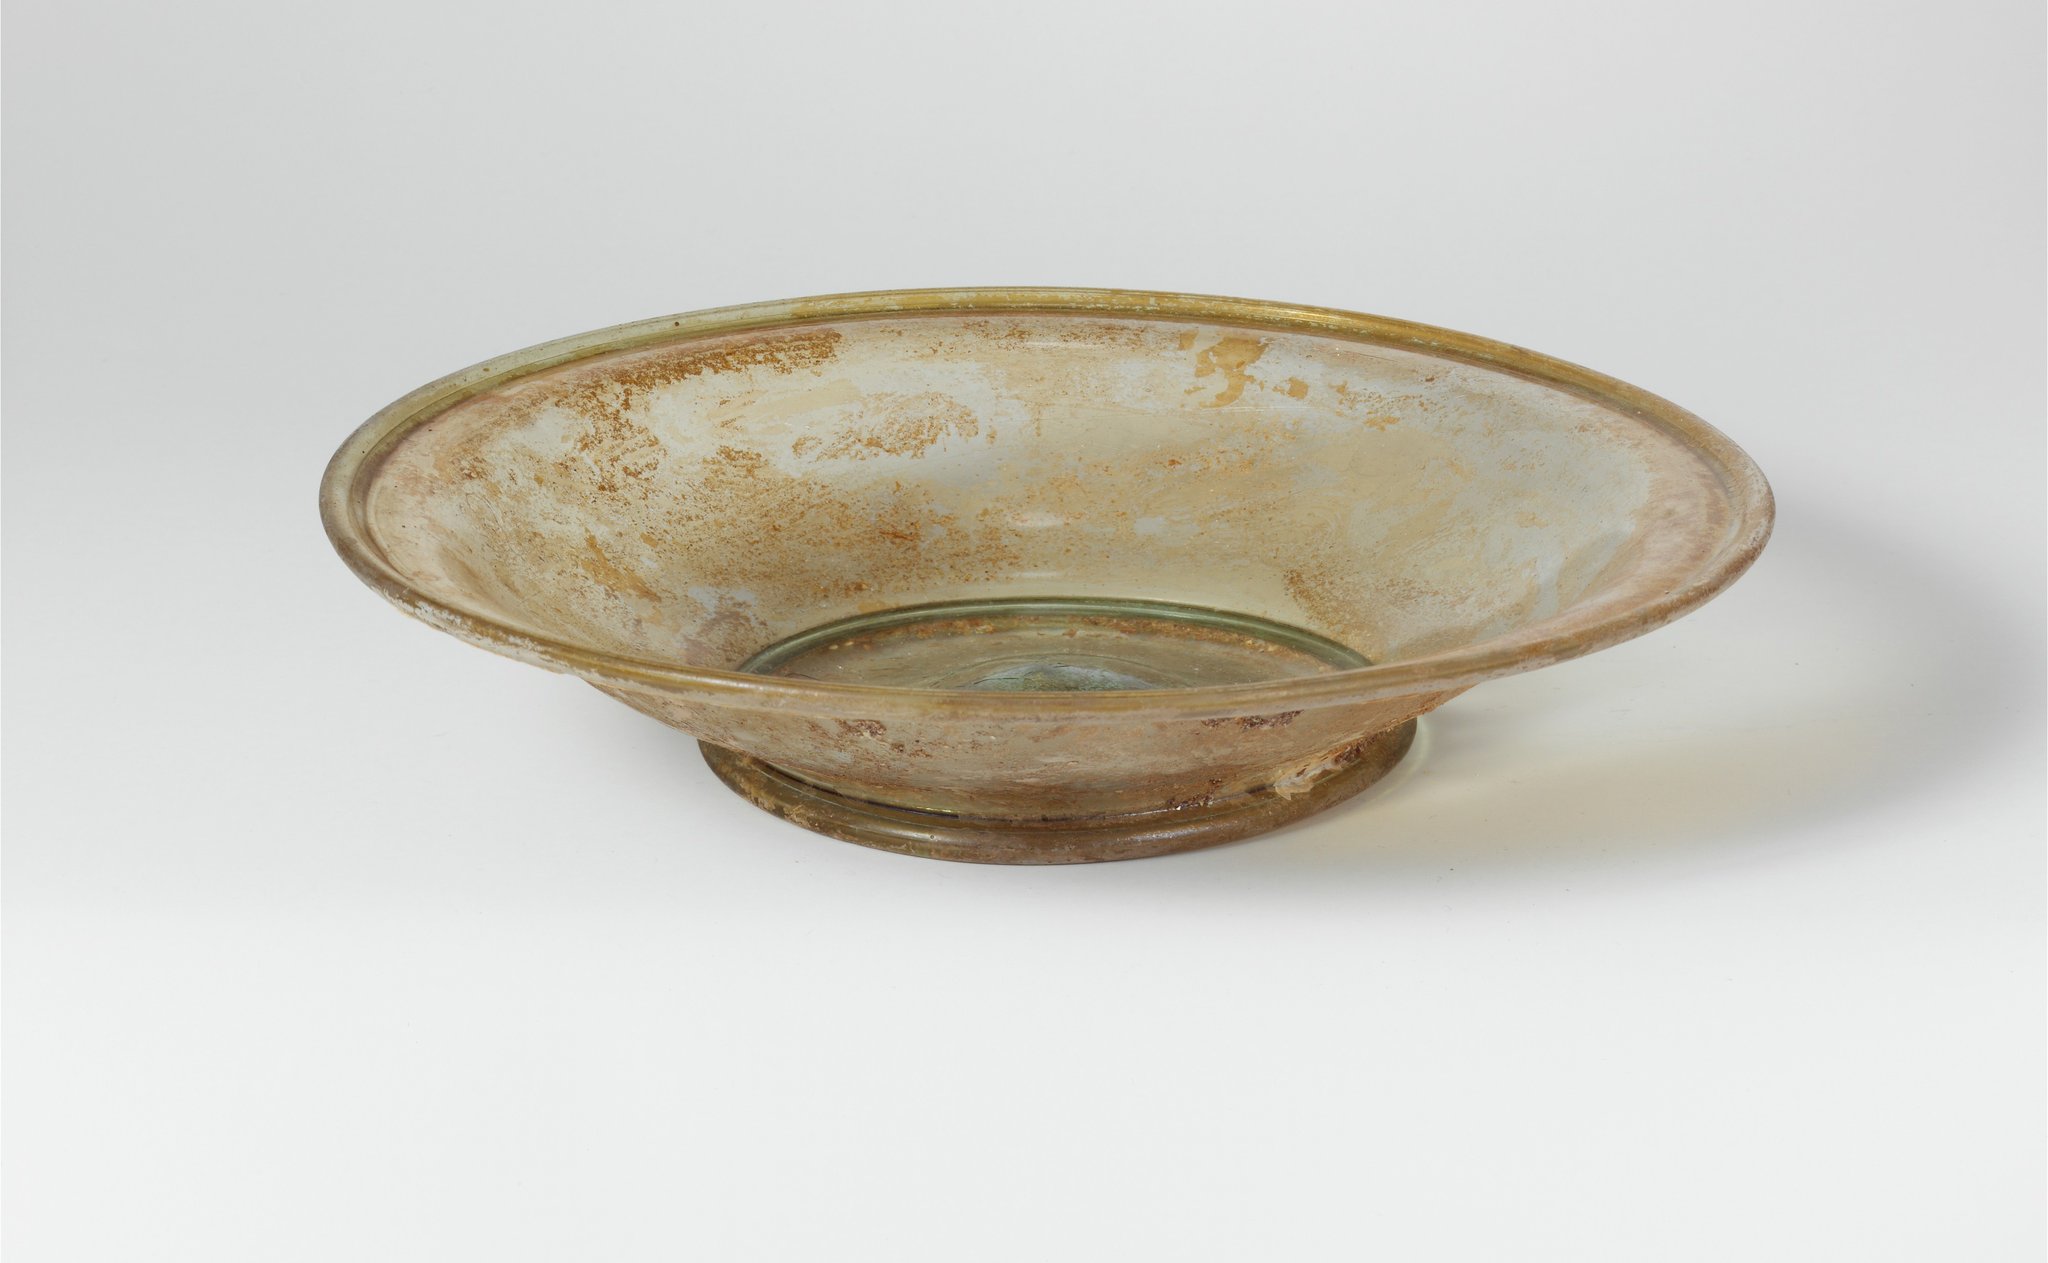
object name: dish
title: Glass dish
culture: roman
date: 301-400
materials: glass